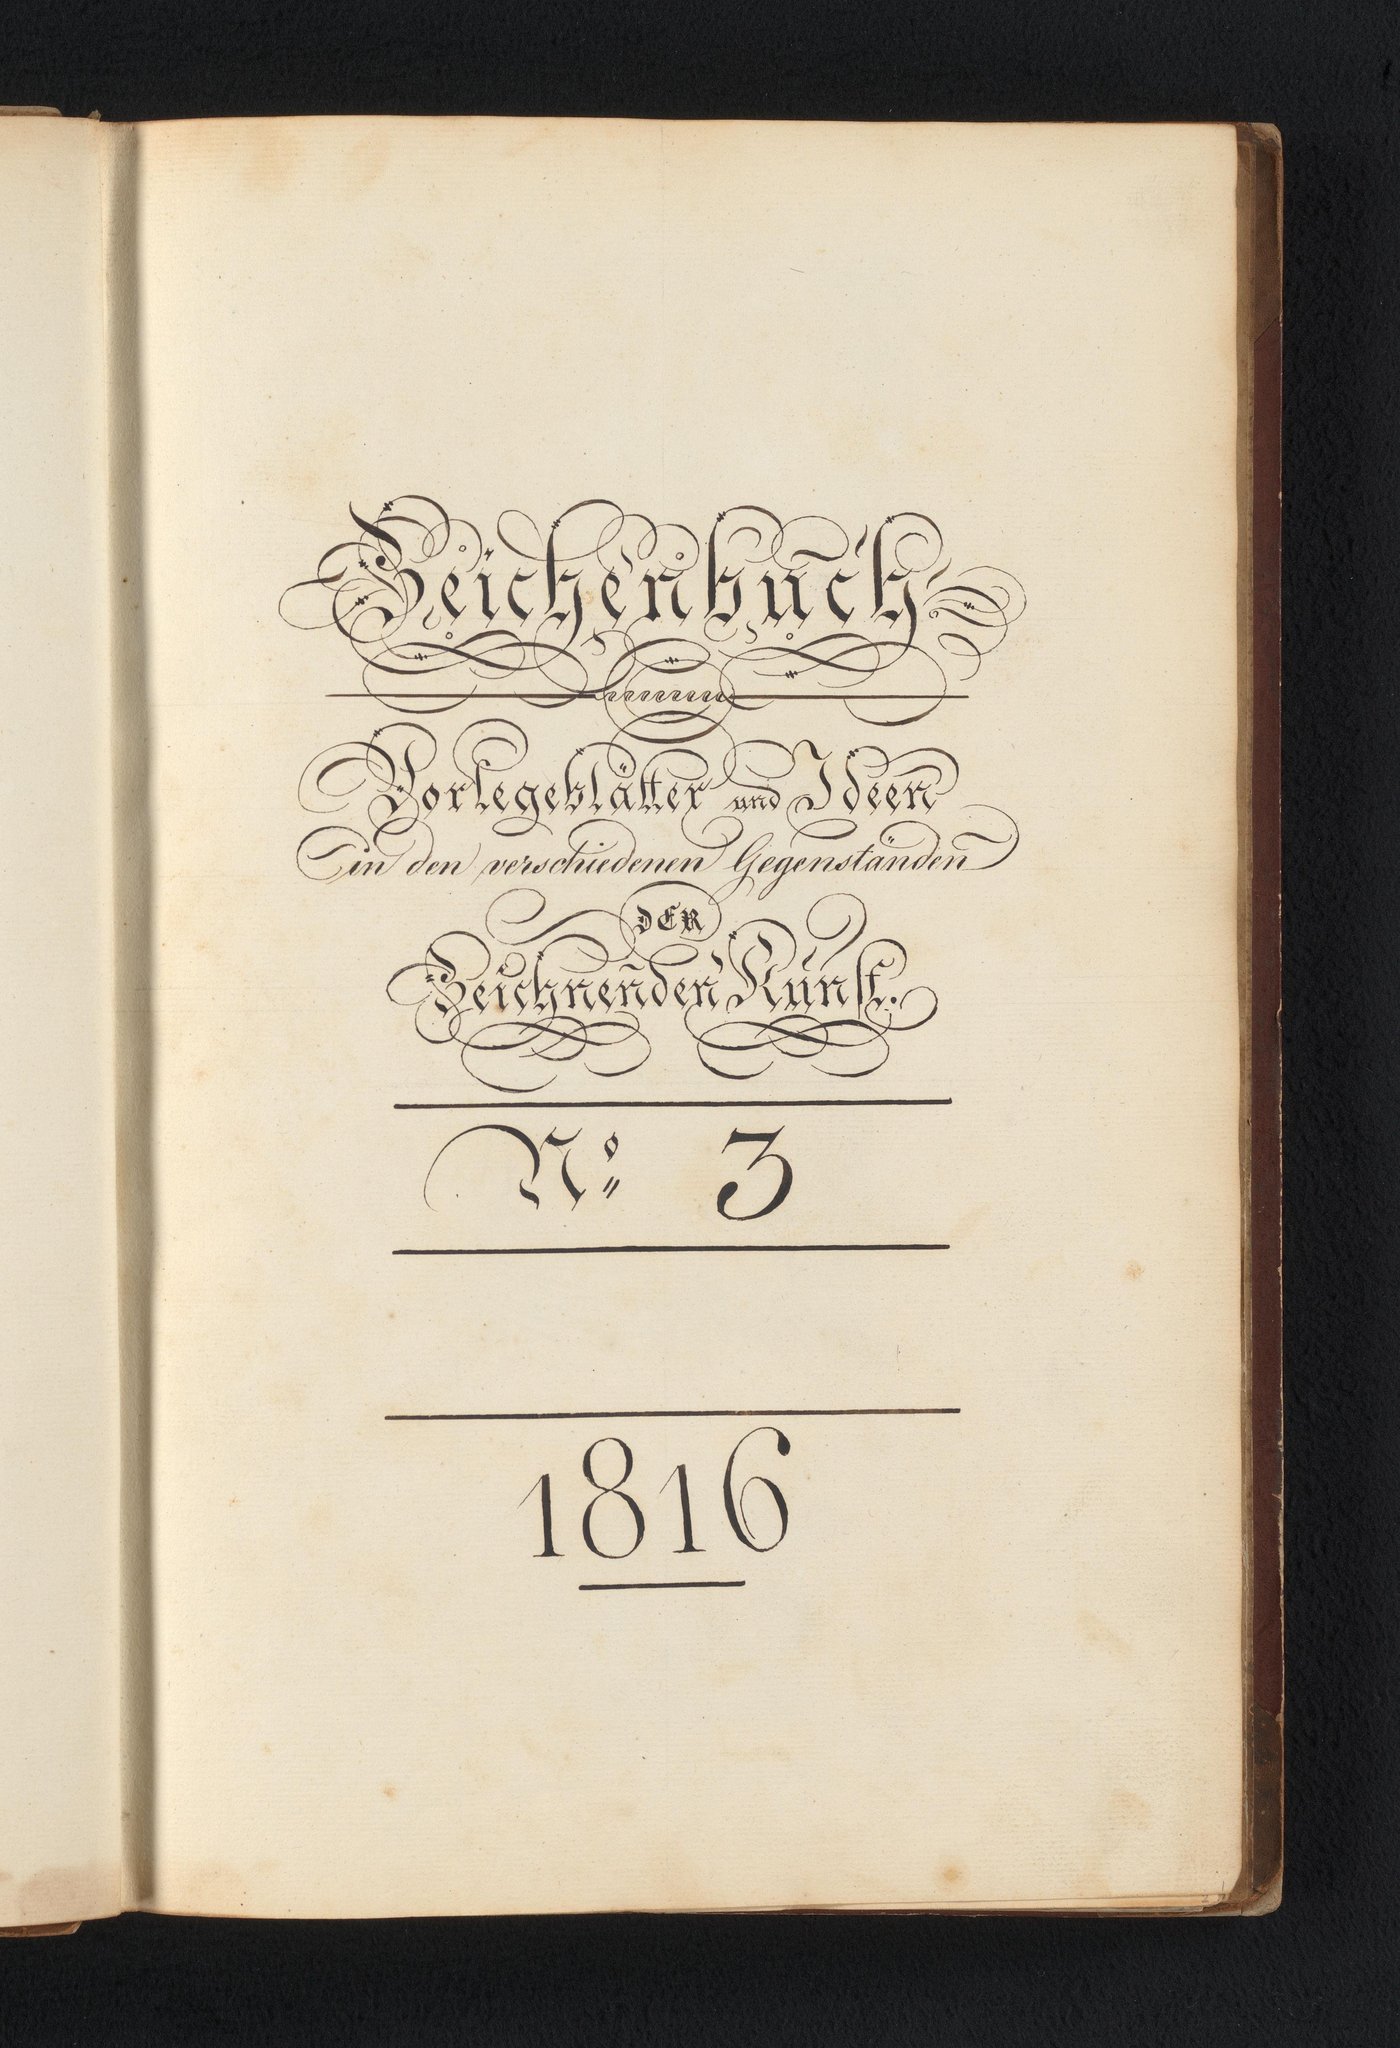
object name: manuscript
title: Titelpagina voor het derde album met tekenvoorbeelden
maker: Anonymous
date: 1816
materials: ink, paper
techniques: pen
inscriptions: date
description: Titelpagina voor het derde album met tekenvoorbeelden. Onderdeel van het tweede van twee albums met ingeplakte prenten en tekeningen te dienen als tekenvoorbeelden.